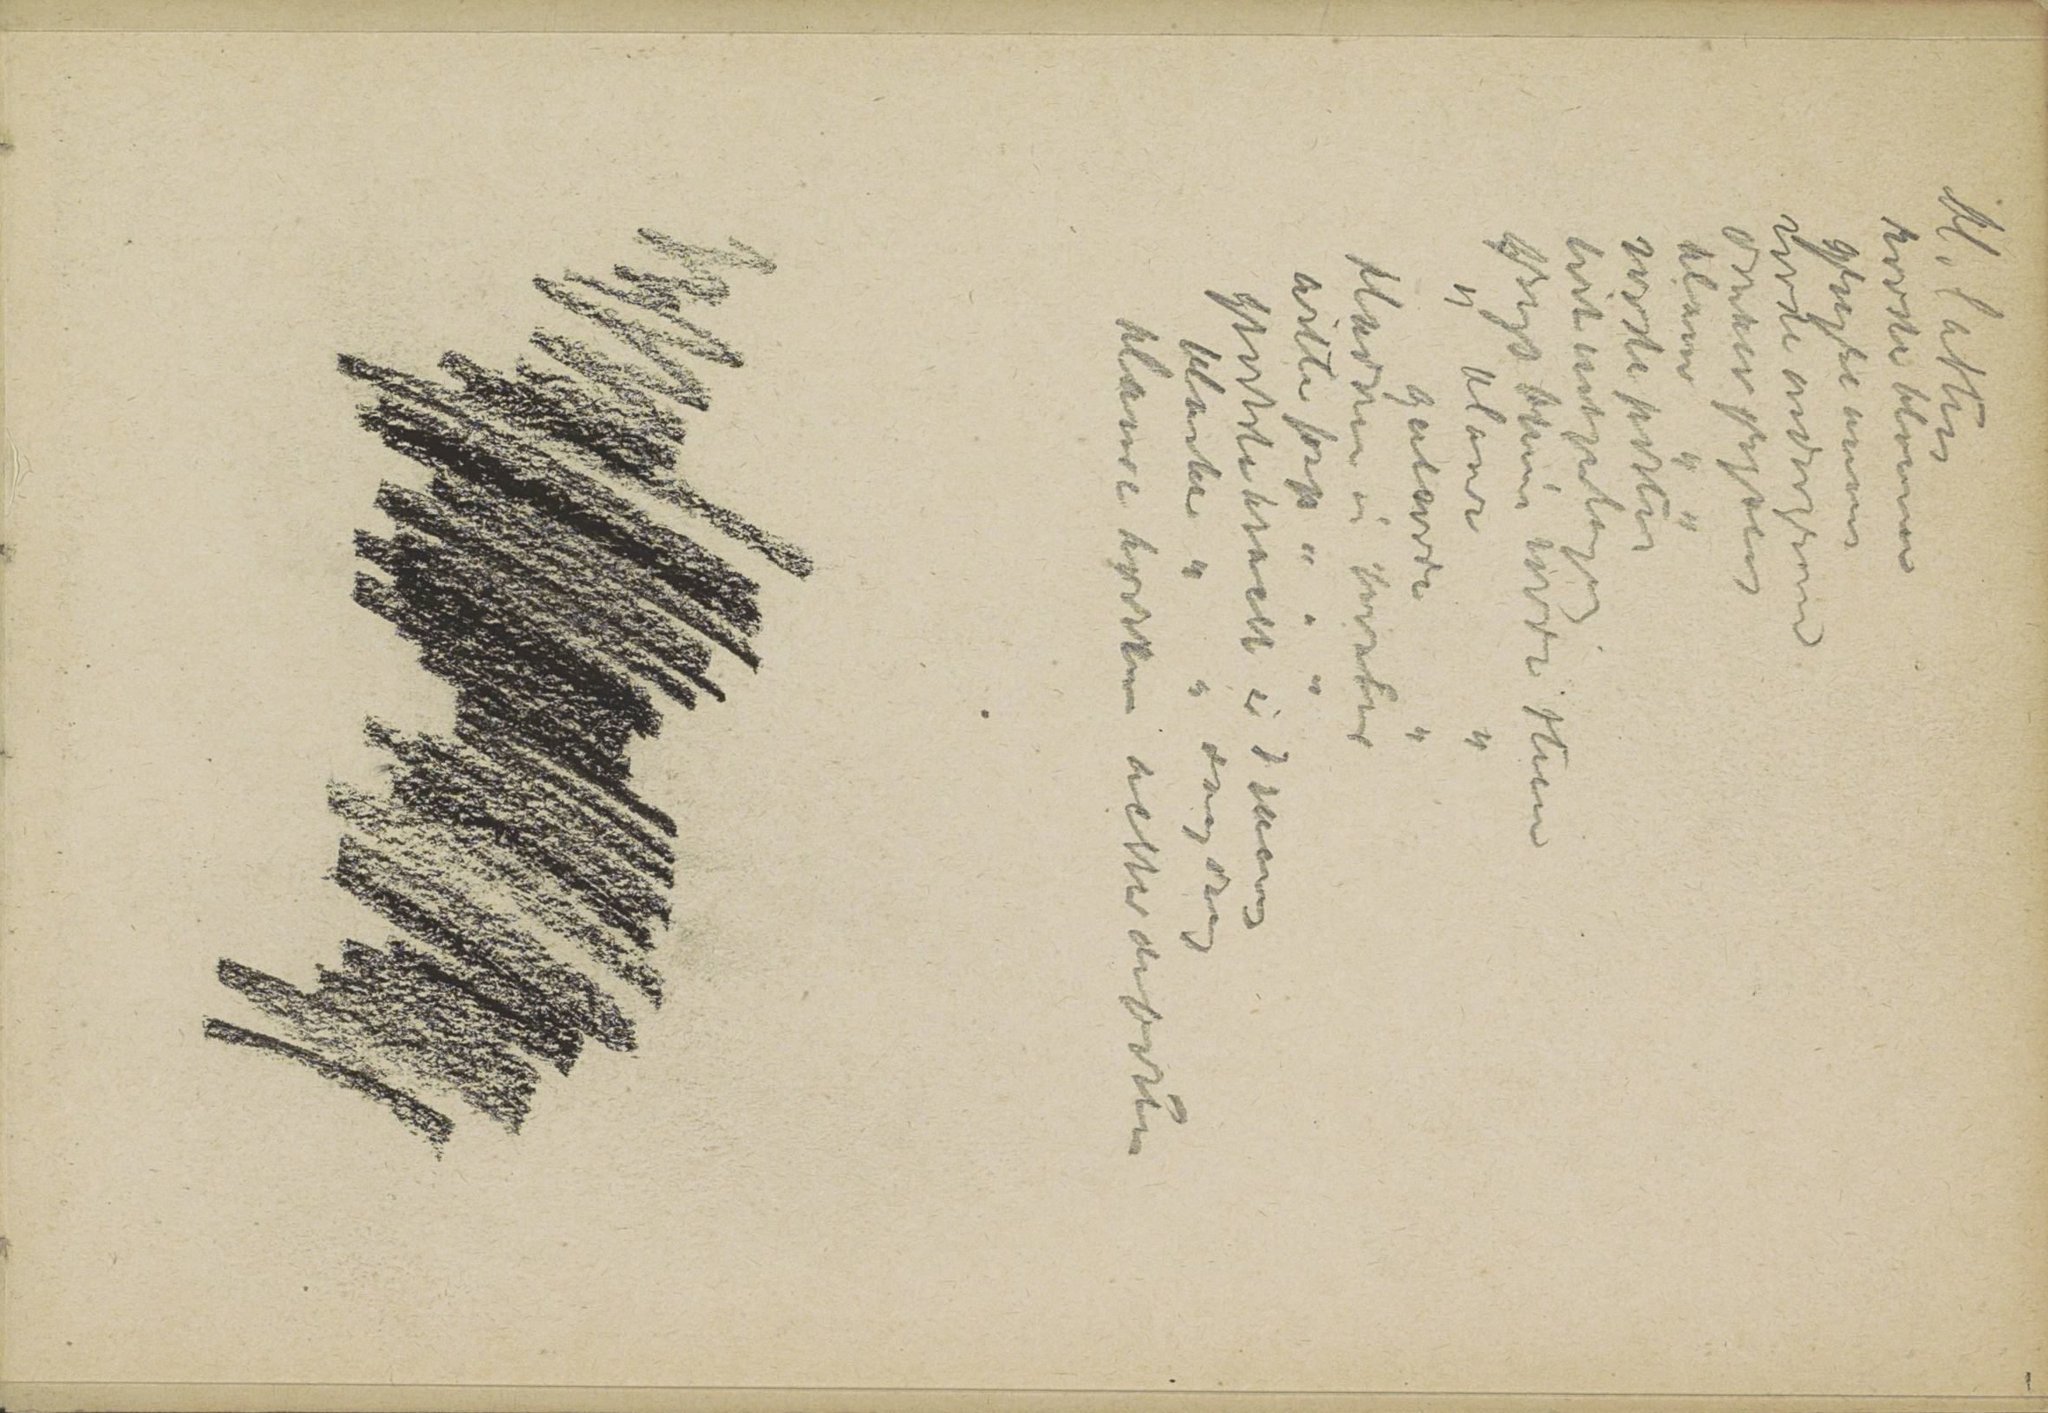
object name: sketchbook leaf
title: Kleurnotities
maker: willem witsen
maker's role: draughtsman, painter, print maker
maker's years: 1860-1923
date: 1887-1920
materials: chalk, paper, pencil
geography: amsterdam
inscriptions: kleurnotitie, handgeschreven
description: Pagina 1 uit een schetsboek met 12 bladen.